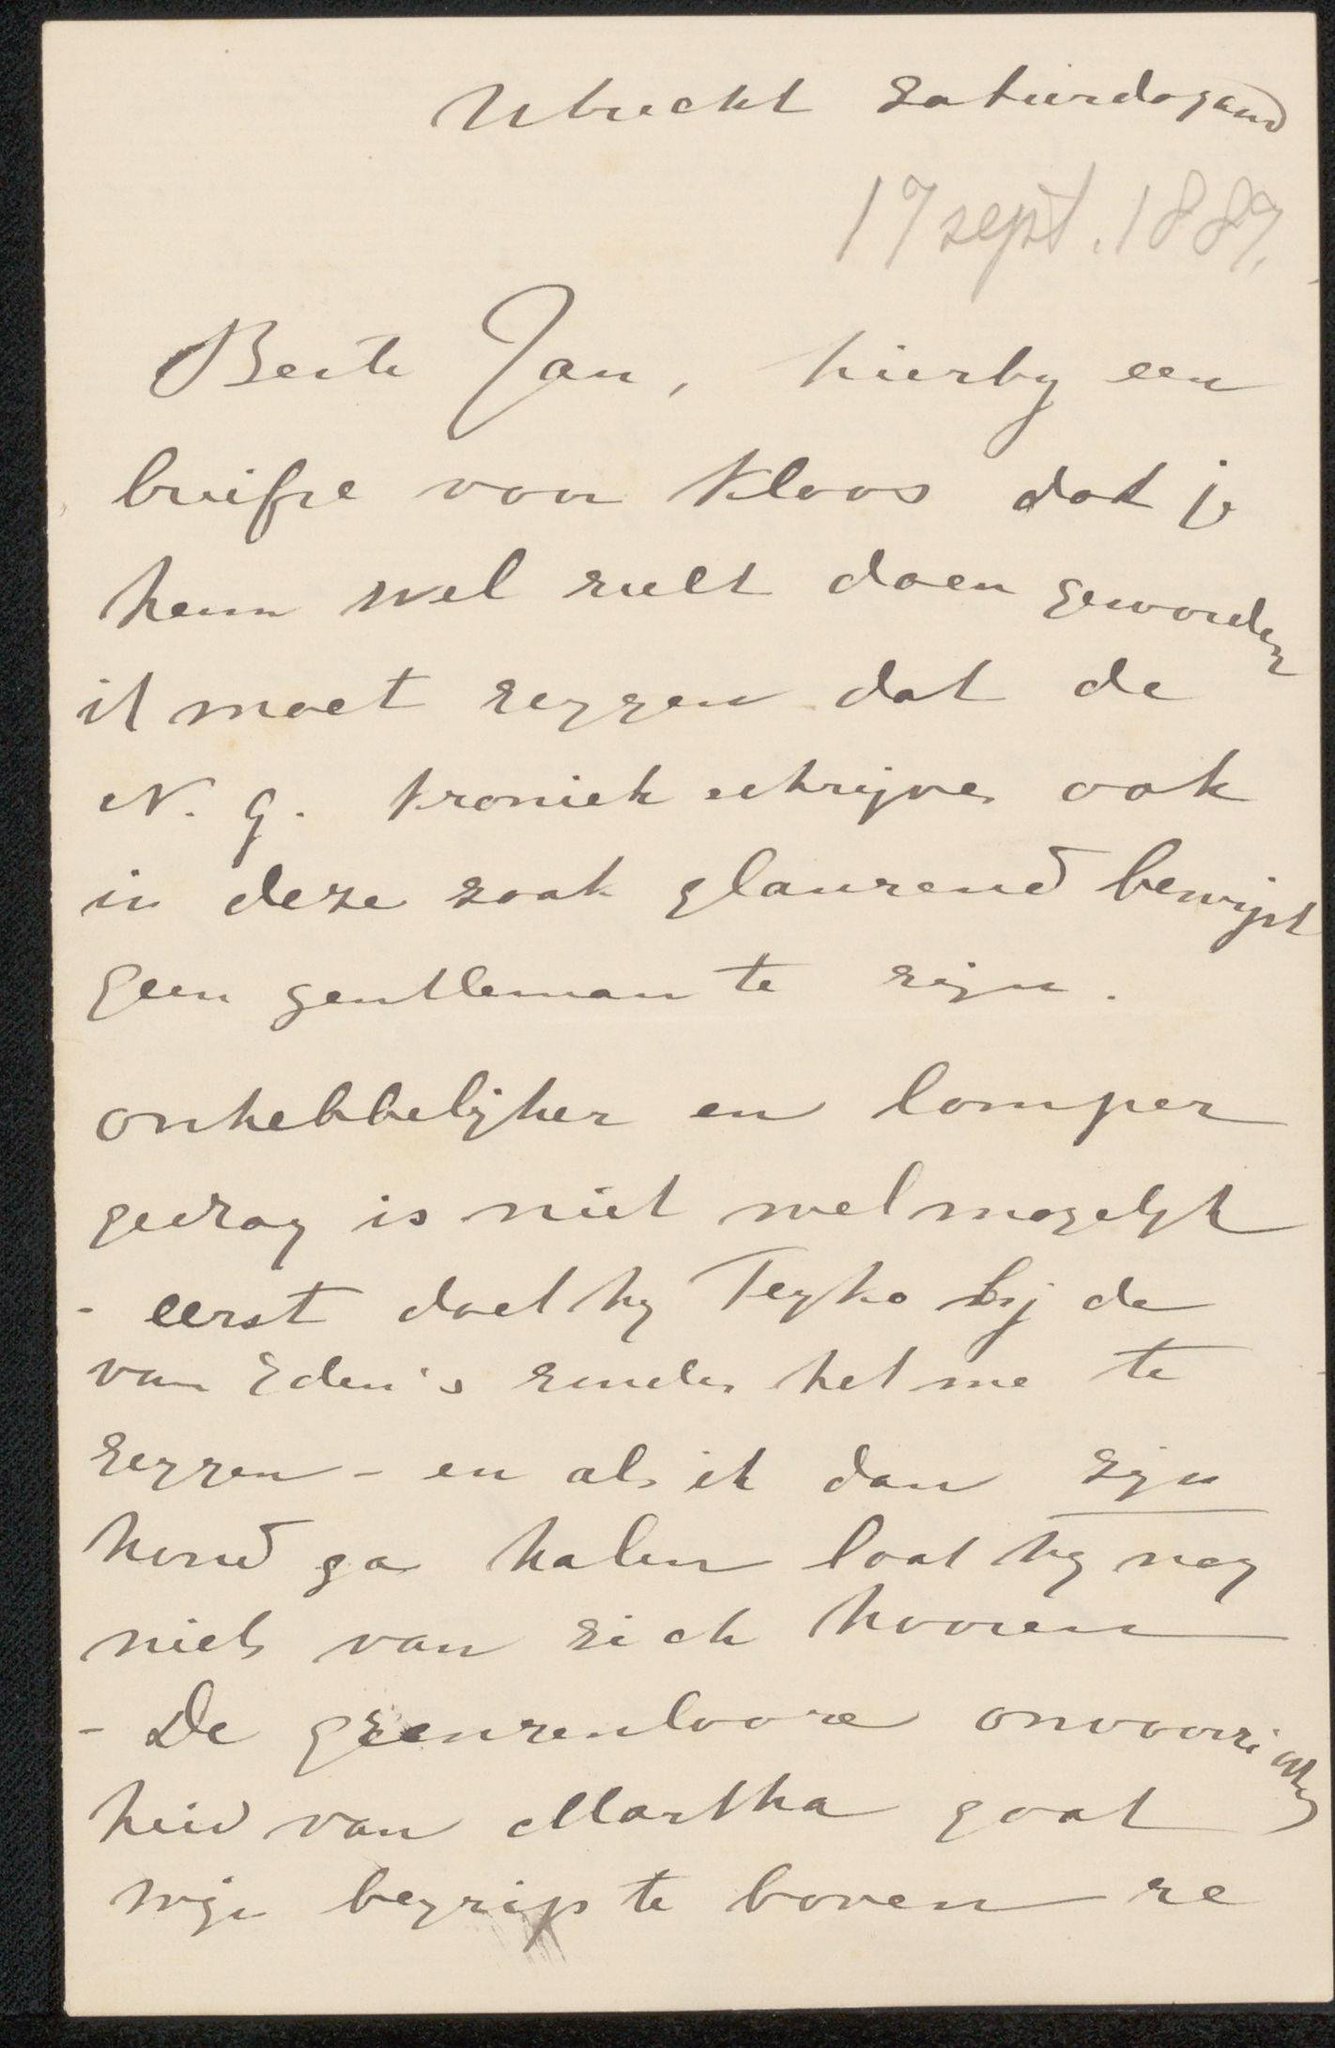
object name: letter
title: Brief aan Jan Veth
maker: etha fles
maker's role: print maker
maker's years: 1857-1948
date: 1874-1925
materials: ink, paper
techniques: pen, writing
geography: utrecht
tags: dordrecht, amsterdam, painter, print maker, draughtsman, designer, jan veth, the hague, willem kloos, deventer, martha van vloten, painting (including book-illumination, miniature-painting), historical persons (portraits and scenes from the life), money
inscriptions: watermark, collector's mark: ‘RPK’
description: Brief gedateerd 17 sept. 1887 in latere hand.